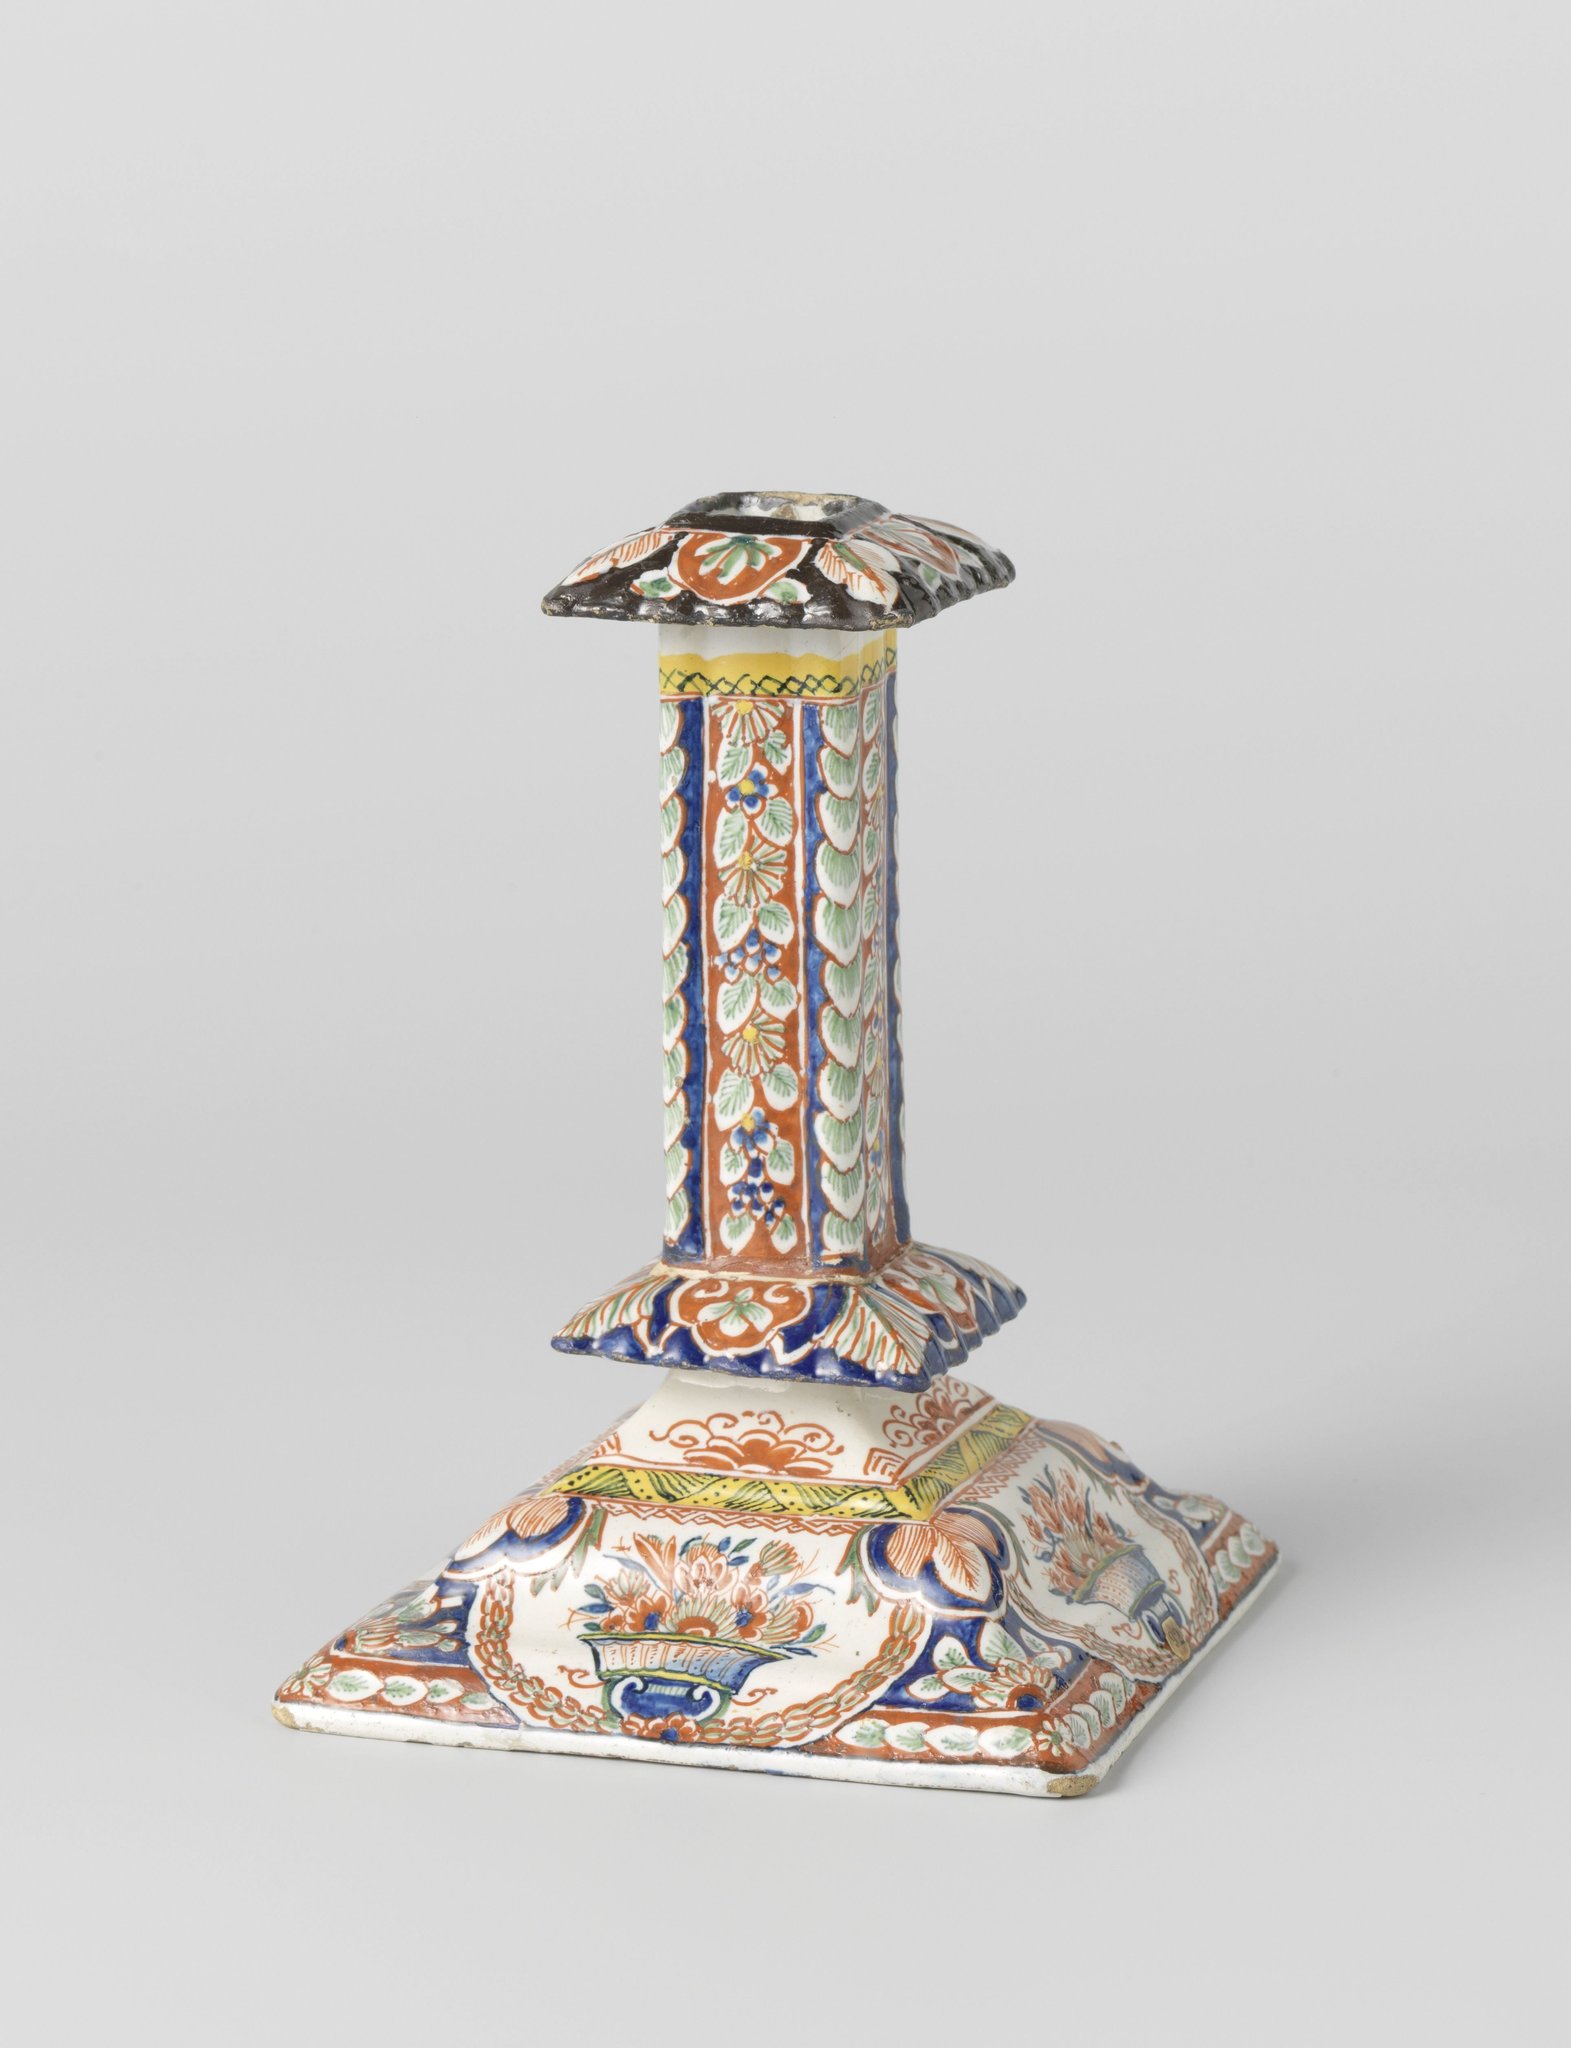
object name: candlestick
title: Kandelaar van veelkleurig beschilderde faïence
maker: Anonymous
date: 1700-1725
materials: faience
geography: delft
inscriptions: collector's mark: ‘collection JF Loudon’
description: Kandelaar van faïence. Veelkleurig beschilderd.